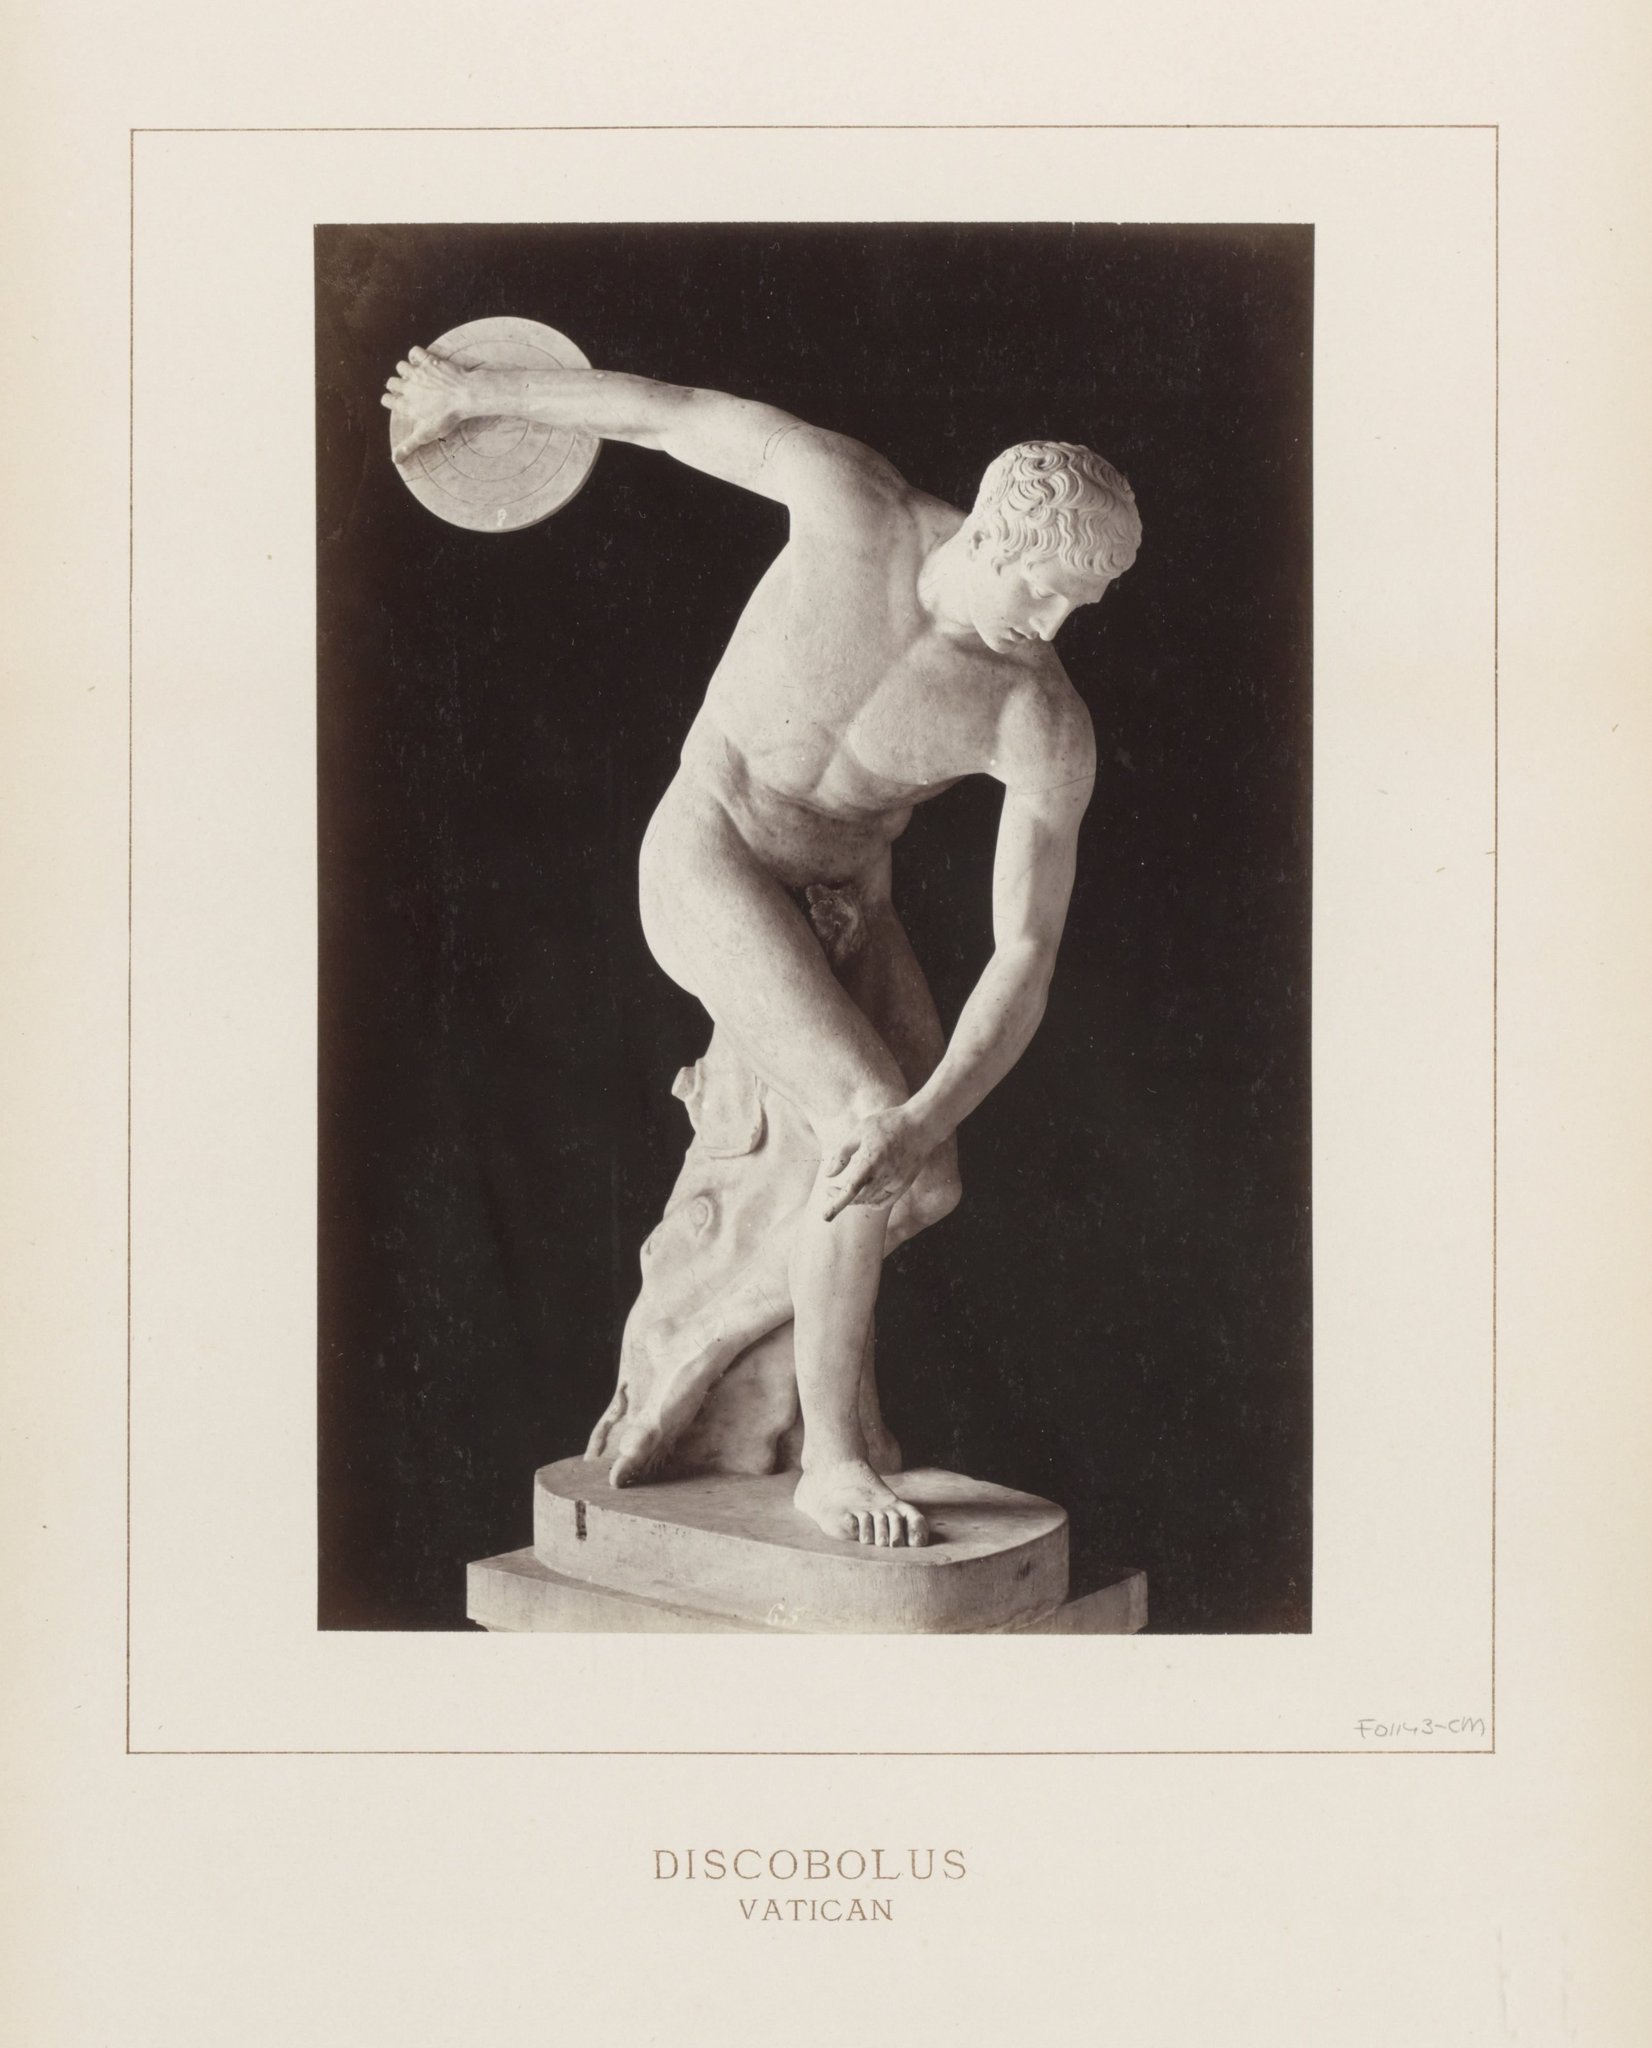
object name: photograph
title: Beeldhouwwerk Discuswerper (diskobolos)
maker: Anonymous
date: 1860-1900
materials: photographic support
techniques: albumen print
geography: vatican city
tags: discus-throwing, piece of sculpture, reproduction of a piece of sculpture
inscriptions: number: ‘65’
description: Onderdeel van Fotoalbum met opnames van bezienswaardigheden en kunstwerken in Rome.